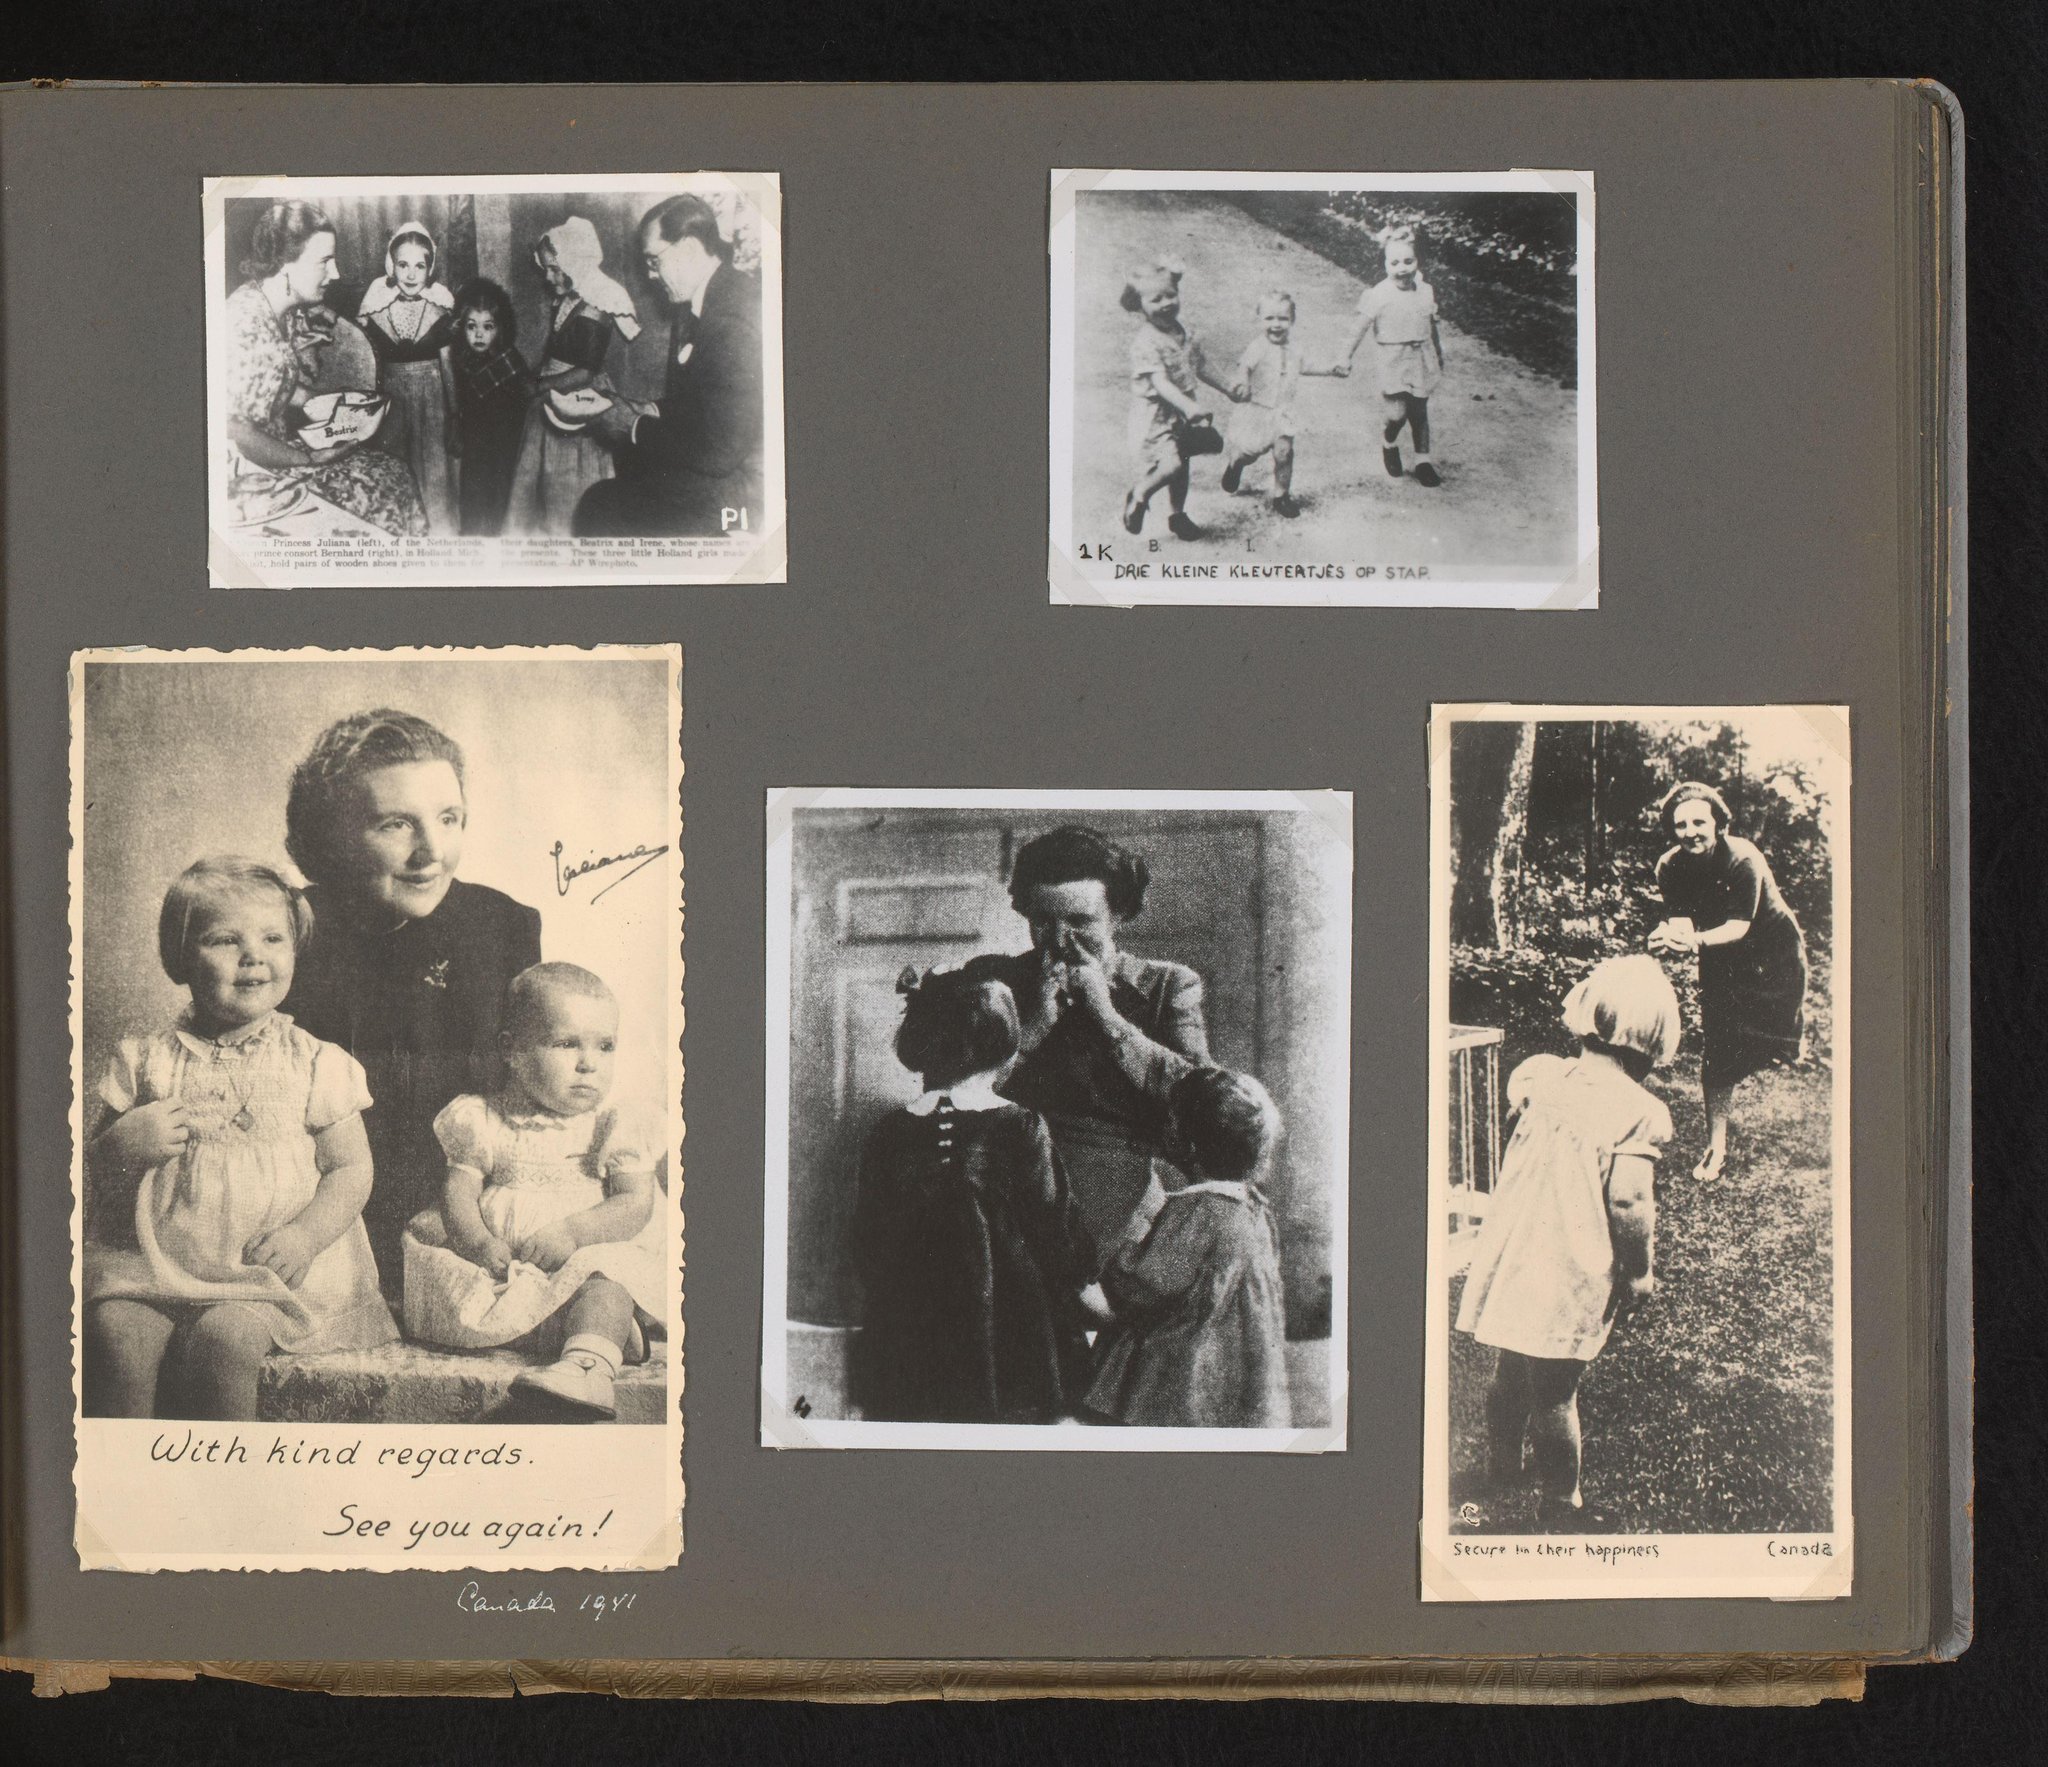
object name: photograph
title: Prinses Juliana met de prinsesjes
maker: Anonymous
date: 1941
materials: cardboard, photographic support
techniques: gelatin silver print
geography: canada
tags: utrecht, bernhard (prins der nederlanden), beatrix (koningin der nederlanden), juliana of the netherlands, parents with their children, canada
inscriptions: inscription: ‘Canada 1941’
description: Albumblad met vijf foto's van prinses Juliana met de prinsessen Beatrix en Irene in Canada, 1941. Onderdeel van fotoalbum over het familieleven van de leden van het Koninklijk Huis tussen 1937-1945.